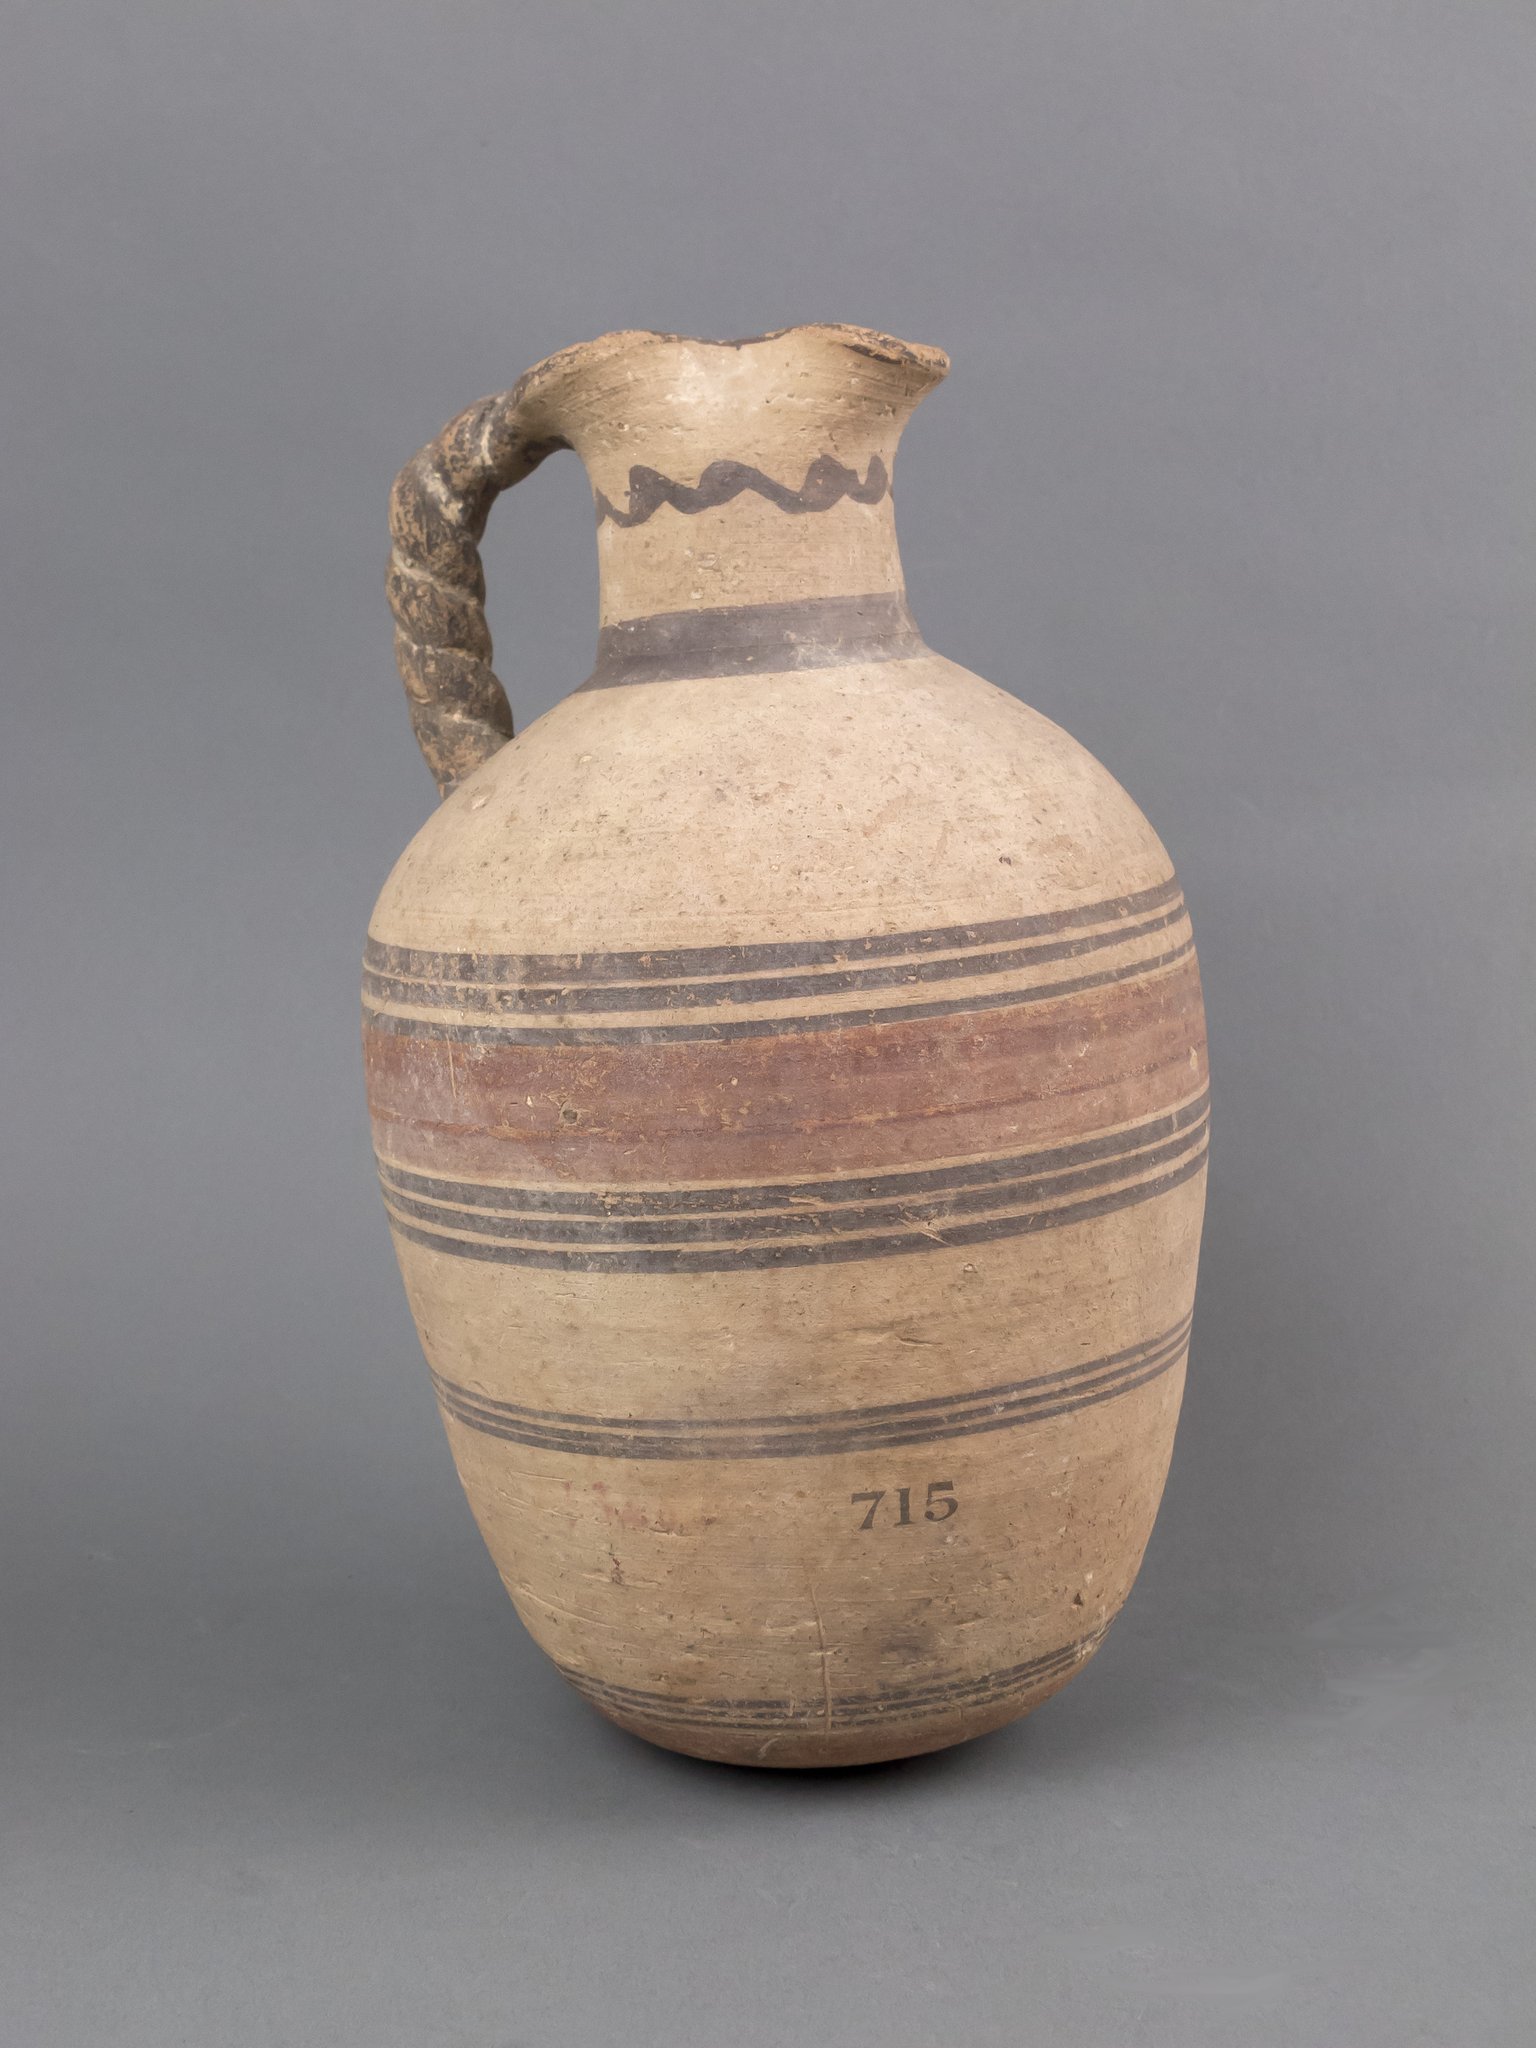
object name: oinochoe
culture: cypriot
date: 1125-1050 BCE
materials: terracotta